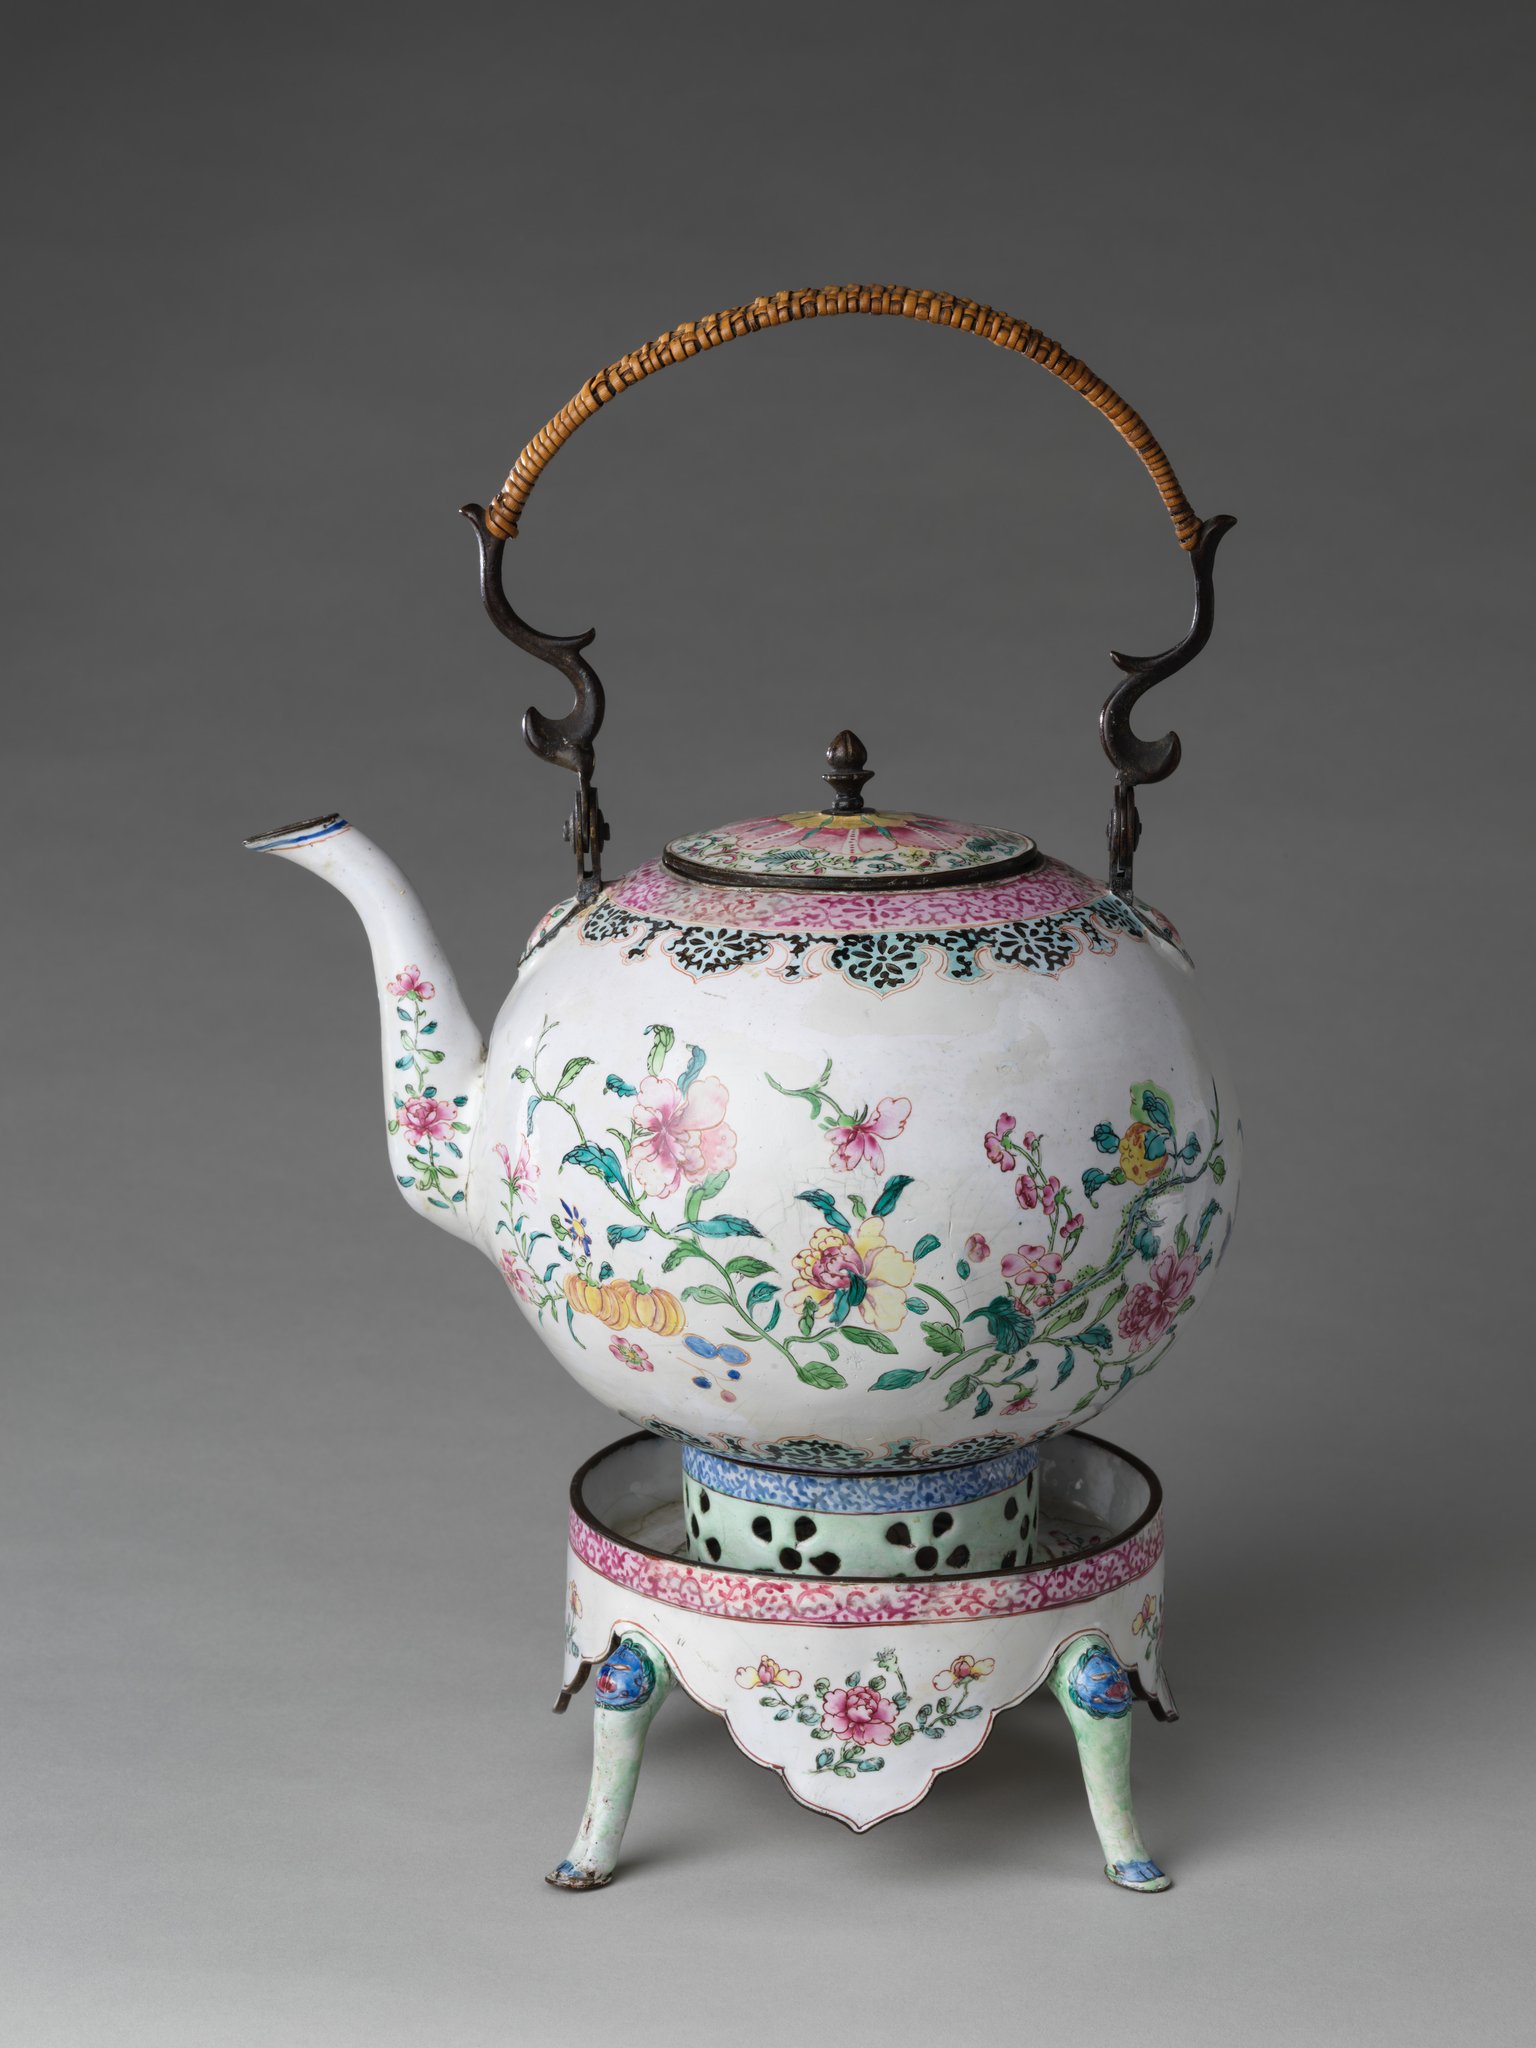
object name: kettle with stand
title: Kettle and stand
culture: chinese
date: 1751-1800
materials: copper alloy, enamel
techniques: painting